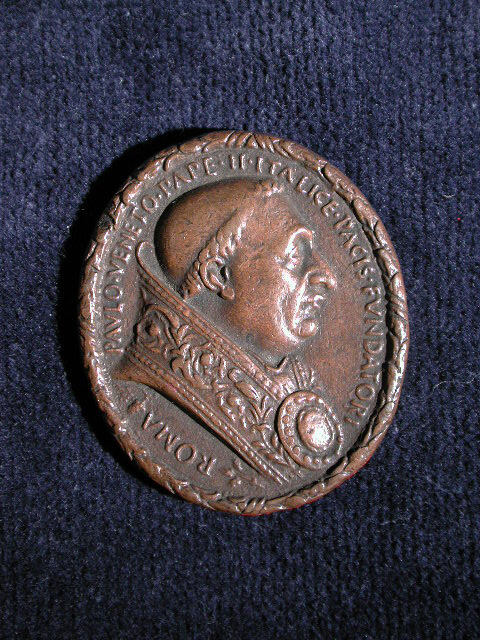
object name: medal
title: Pope Paul II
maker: cristoforo di geremia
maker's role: maker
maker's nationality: italian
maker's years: 1456-1476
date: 1401-1500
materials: bronze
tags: men,profiles,coat of arms